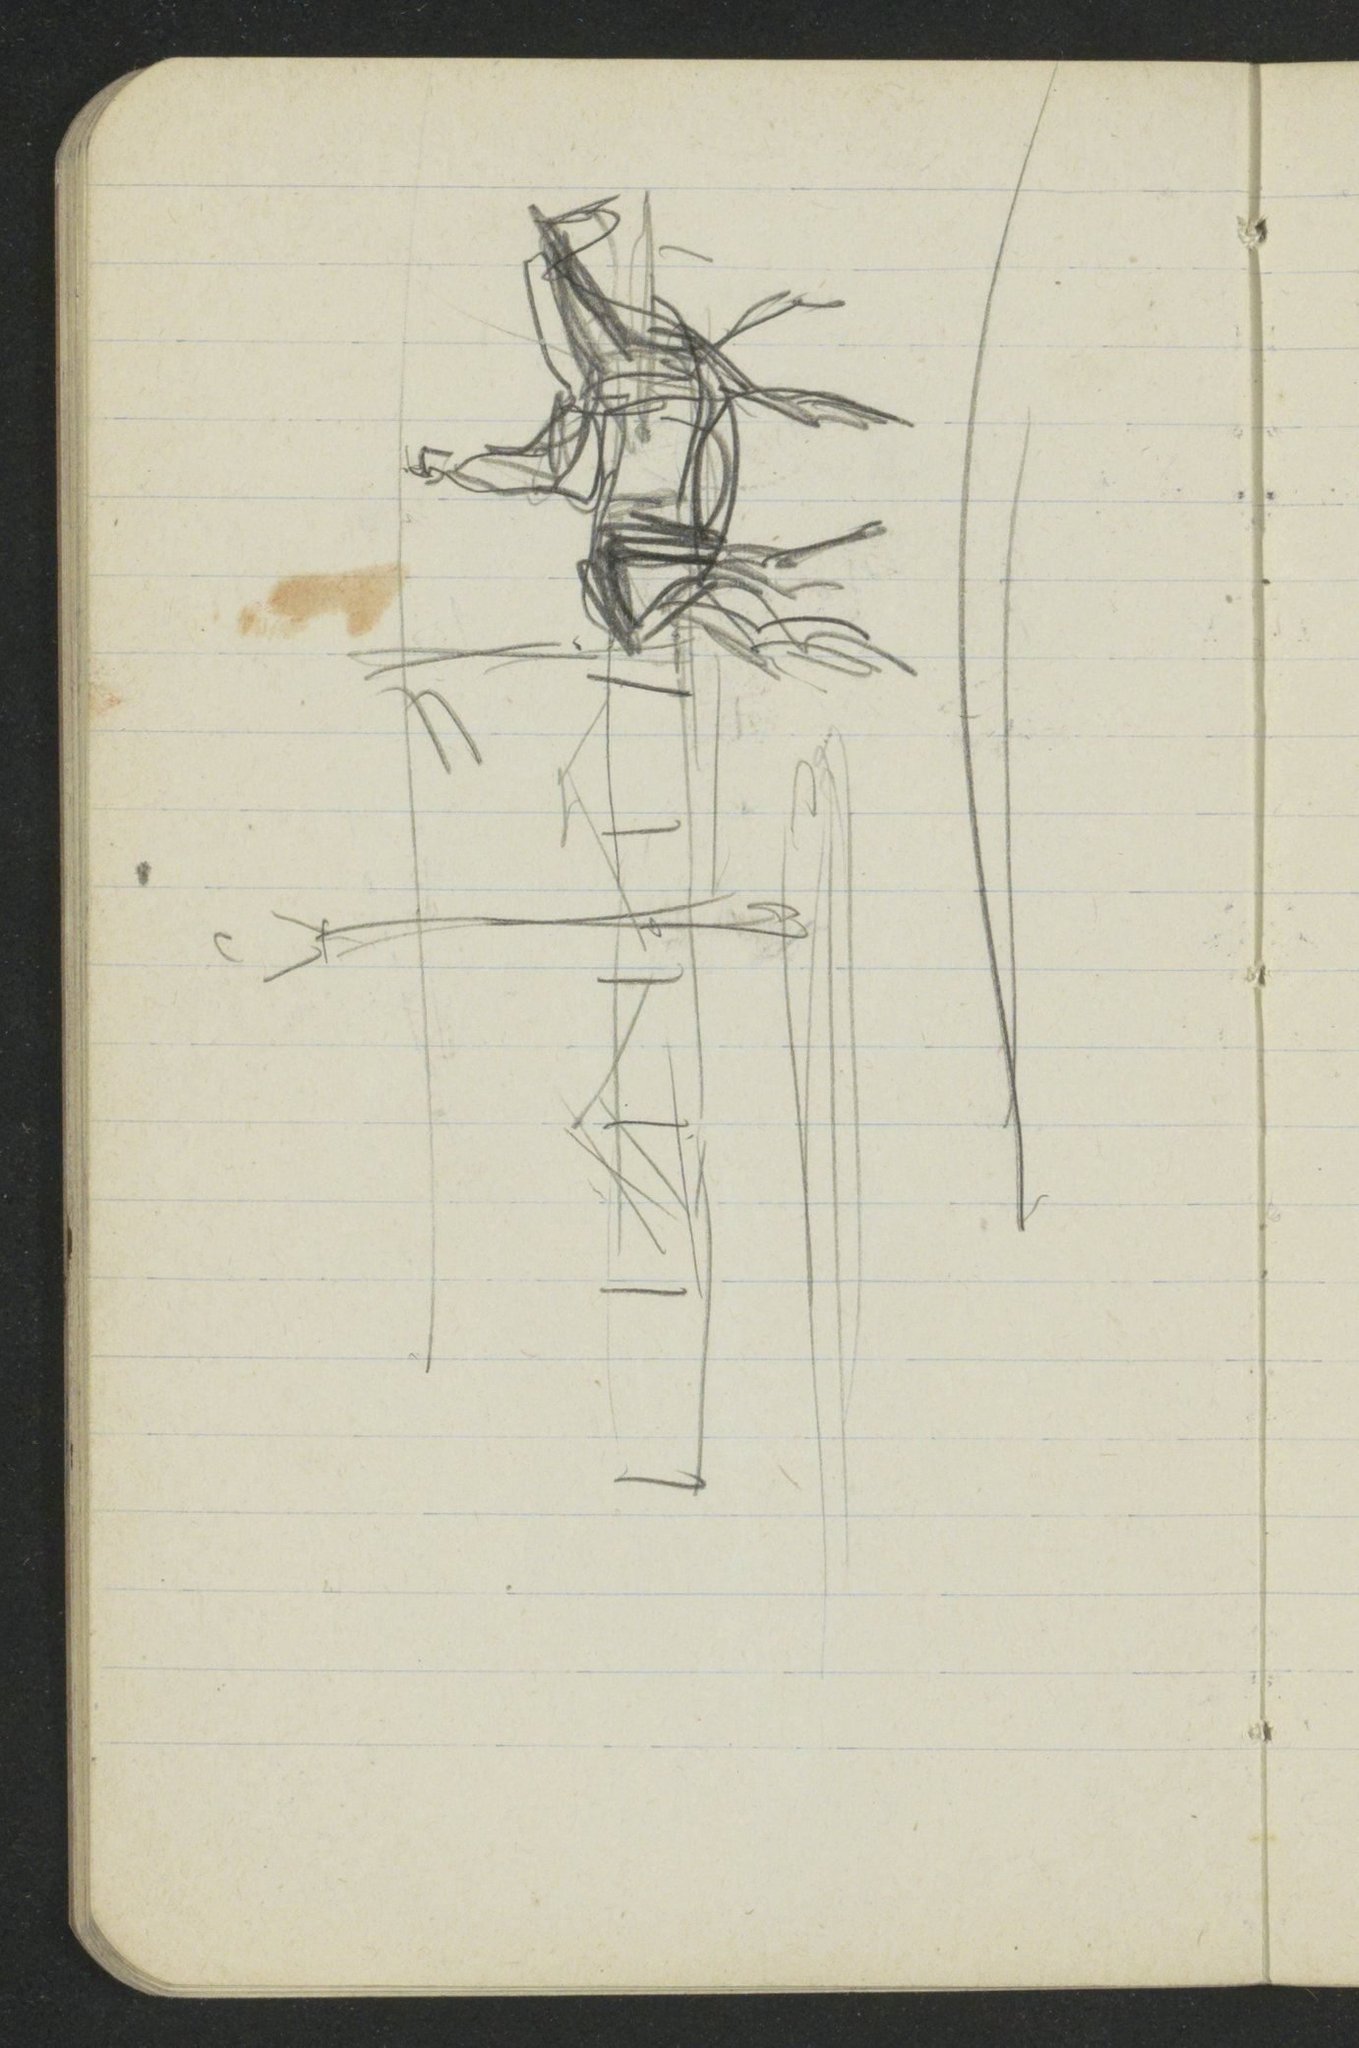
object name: sketchbook leaf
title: Ruiter, mogelijk op de boulevard van Scheveningen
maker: isaac israels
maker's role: draughtsman, painter, print maker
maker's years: 1865-1934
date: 1875-1934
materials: pencil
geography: the hague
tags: riding a horse, ass, or mule; rider, horseman, avenue, boulevard, promenade, esplanade (+ city(-scape) with figures, staffage)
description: Pagina 24 uit schetsboek XL met 40 pagina's.